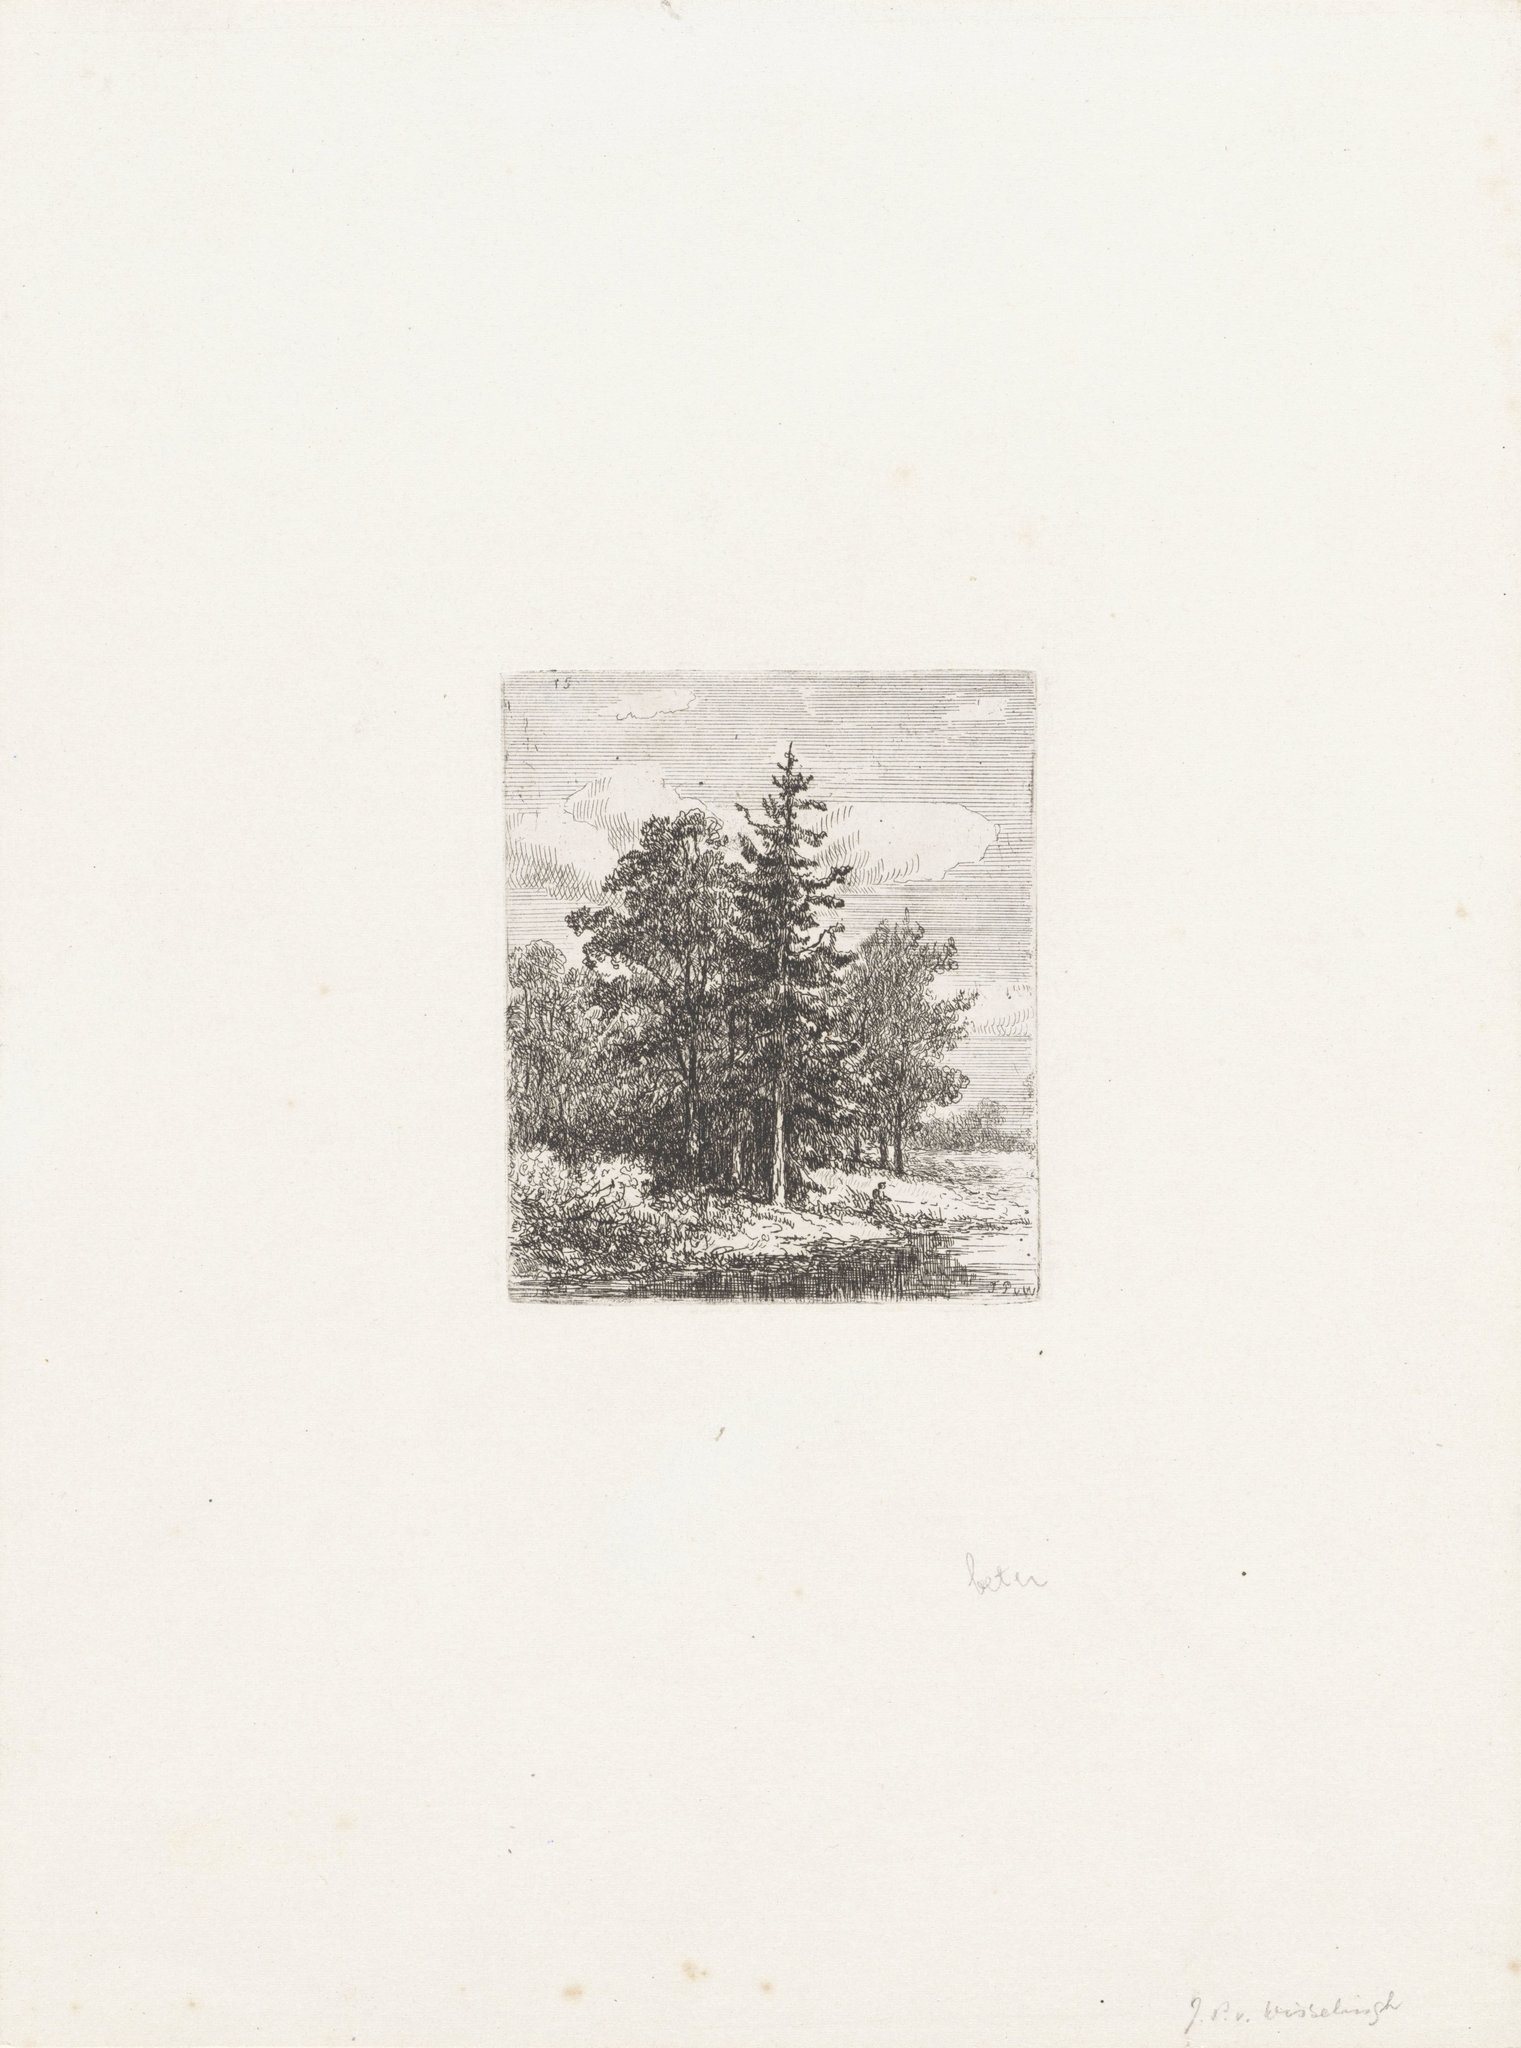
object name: print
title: Visser voor een groep bomen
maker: johannes pieter van wisselingh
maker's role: draughtsman, painter, print maker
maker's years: 1812-1899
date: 1830-1878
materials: paper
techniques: etching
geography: netherlands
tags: river, trees: oak, trees: fir, fisherman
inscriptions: collector's mark: Lugt 2233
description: Aan de oever van een rivier zit een visser. Achter hem staan verschillende bomen, waaronder een eik en een spar. Linksboven het getal 15.